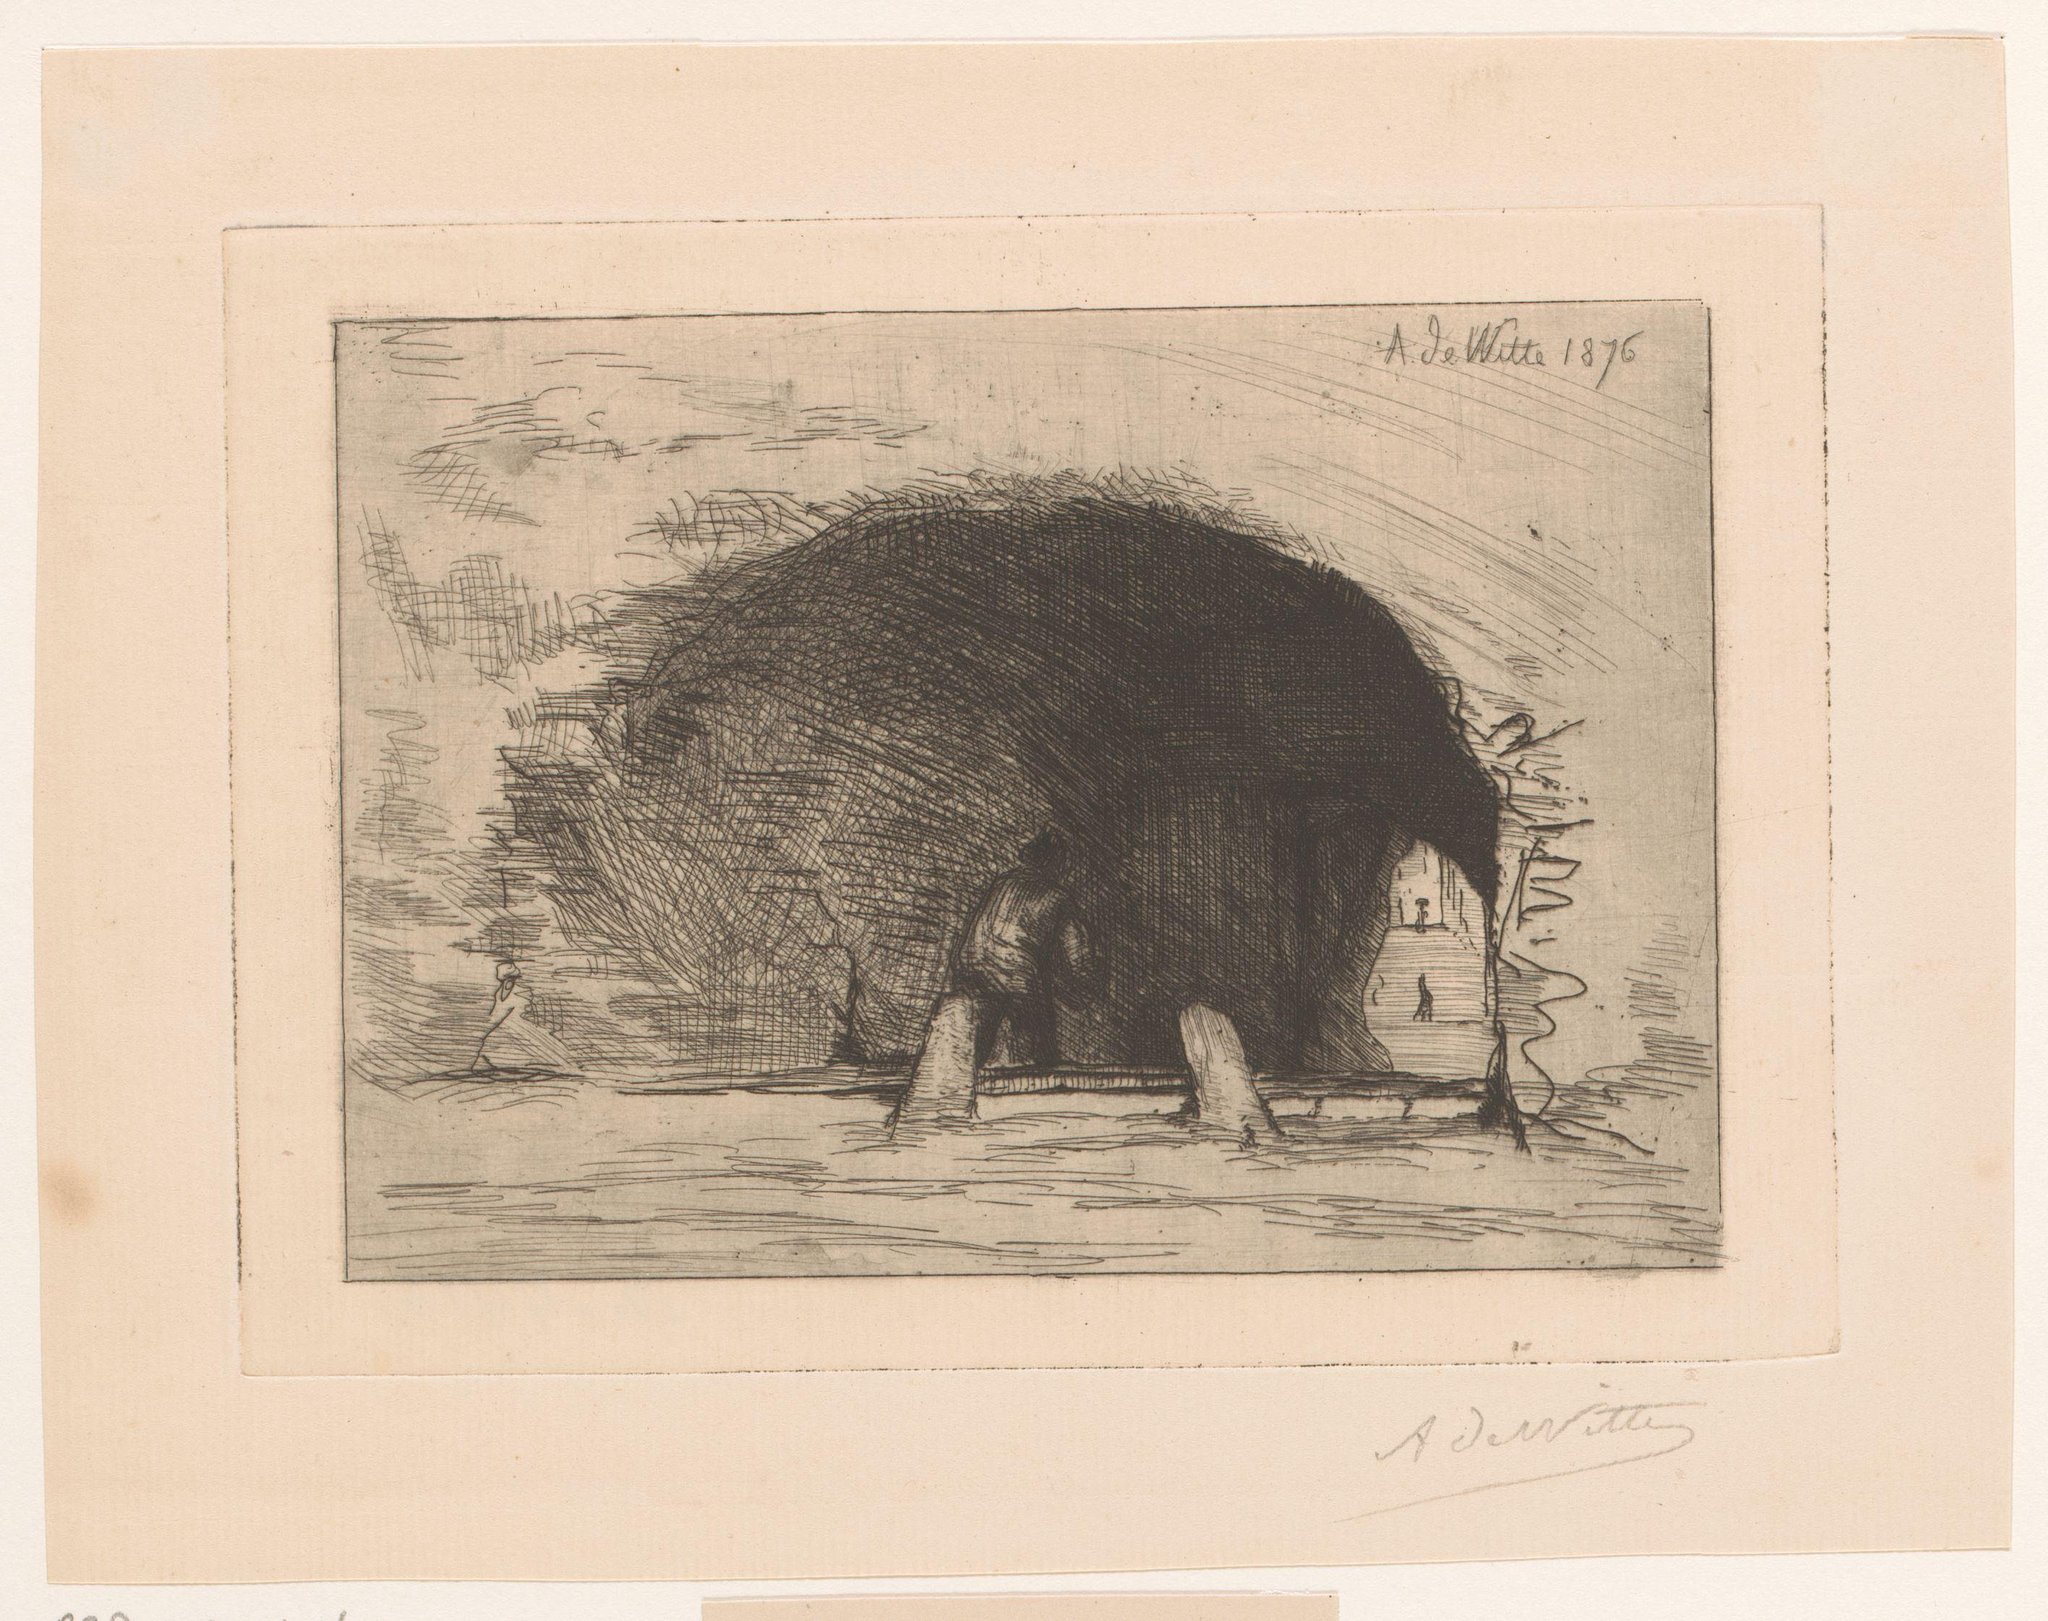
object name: print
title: Figuur loopt door een tunnel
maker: adrien de witte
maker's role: print maker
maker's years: 1850-1935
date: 1876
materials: paper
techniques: etching, intaglio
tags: walking, underground road, tunnel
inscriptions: collector's mark: Lugt 2228